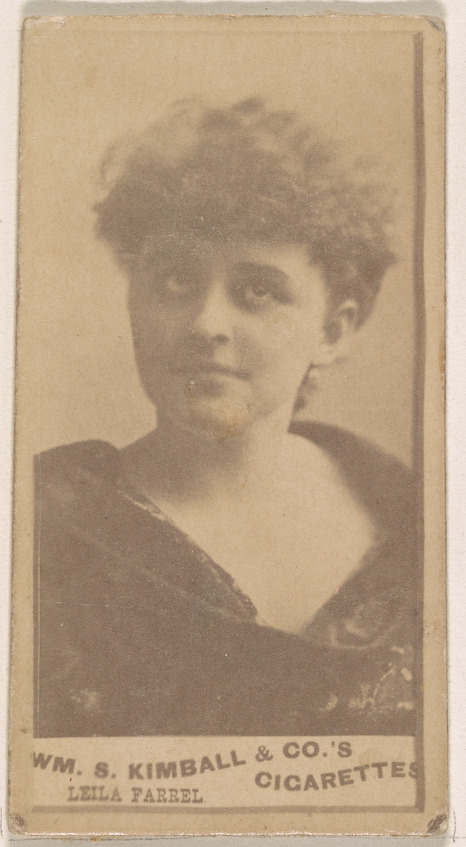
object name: photograph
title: Leila Farrel, from the Actresses series (N203) issued by Wm. S. Kimball & Co.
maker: william s. kimball & company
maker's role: publisher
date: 1889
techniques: color lithograph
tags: portraits,women,actresses